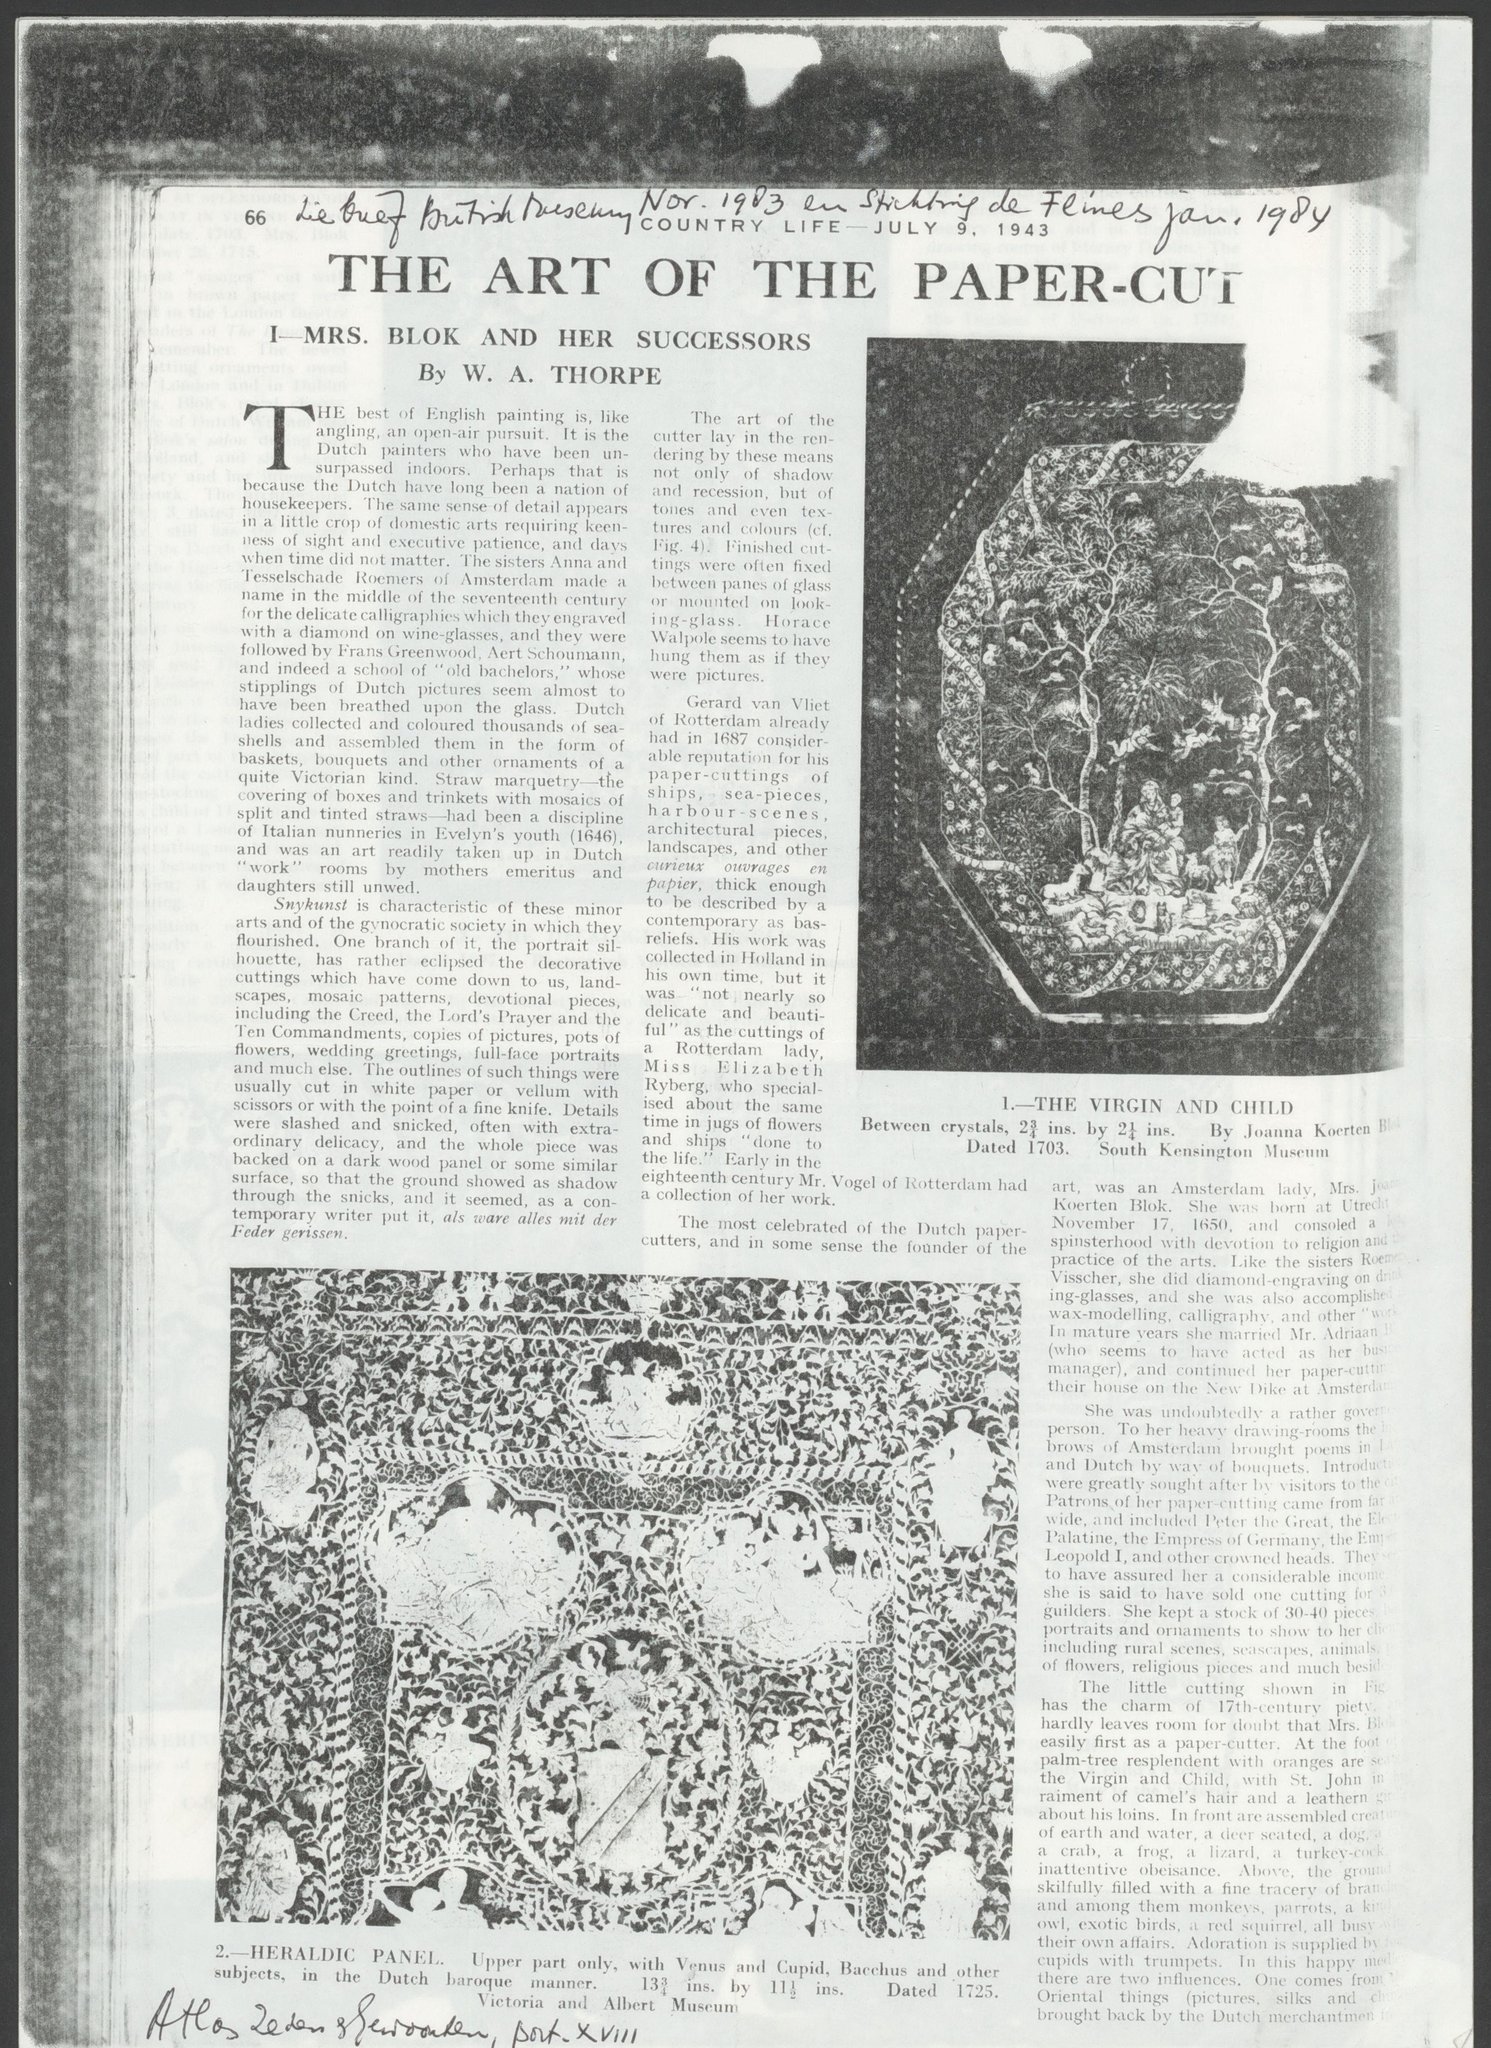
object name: text sheet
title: The art of the paper-cut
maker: w.a. thorpe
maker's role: schrijver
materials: paper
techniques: photocopy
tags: amsterdam, draughtsman, johanna koerten, applied arts, arts and crafts; industrial design, historical persons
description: Vijf pagina's met twee artikelen over knipselkunst uit het tijdschrift Country Life. Onderwerpsrubrieken binnen de Atlas Zeden en Gewoonten: Schoone kunsten, Knipkunst.